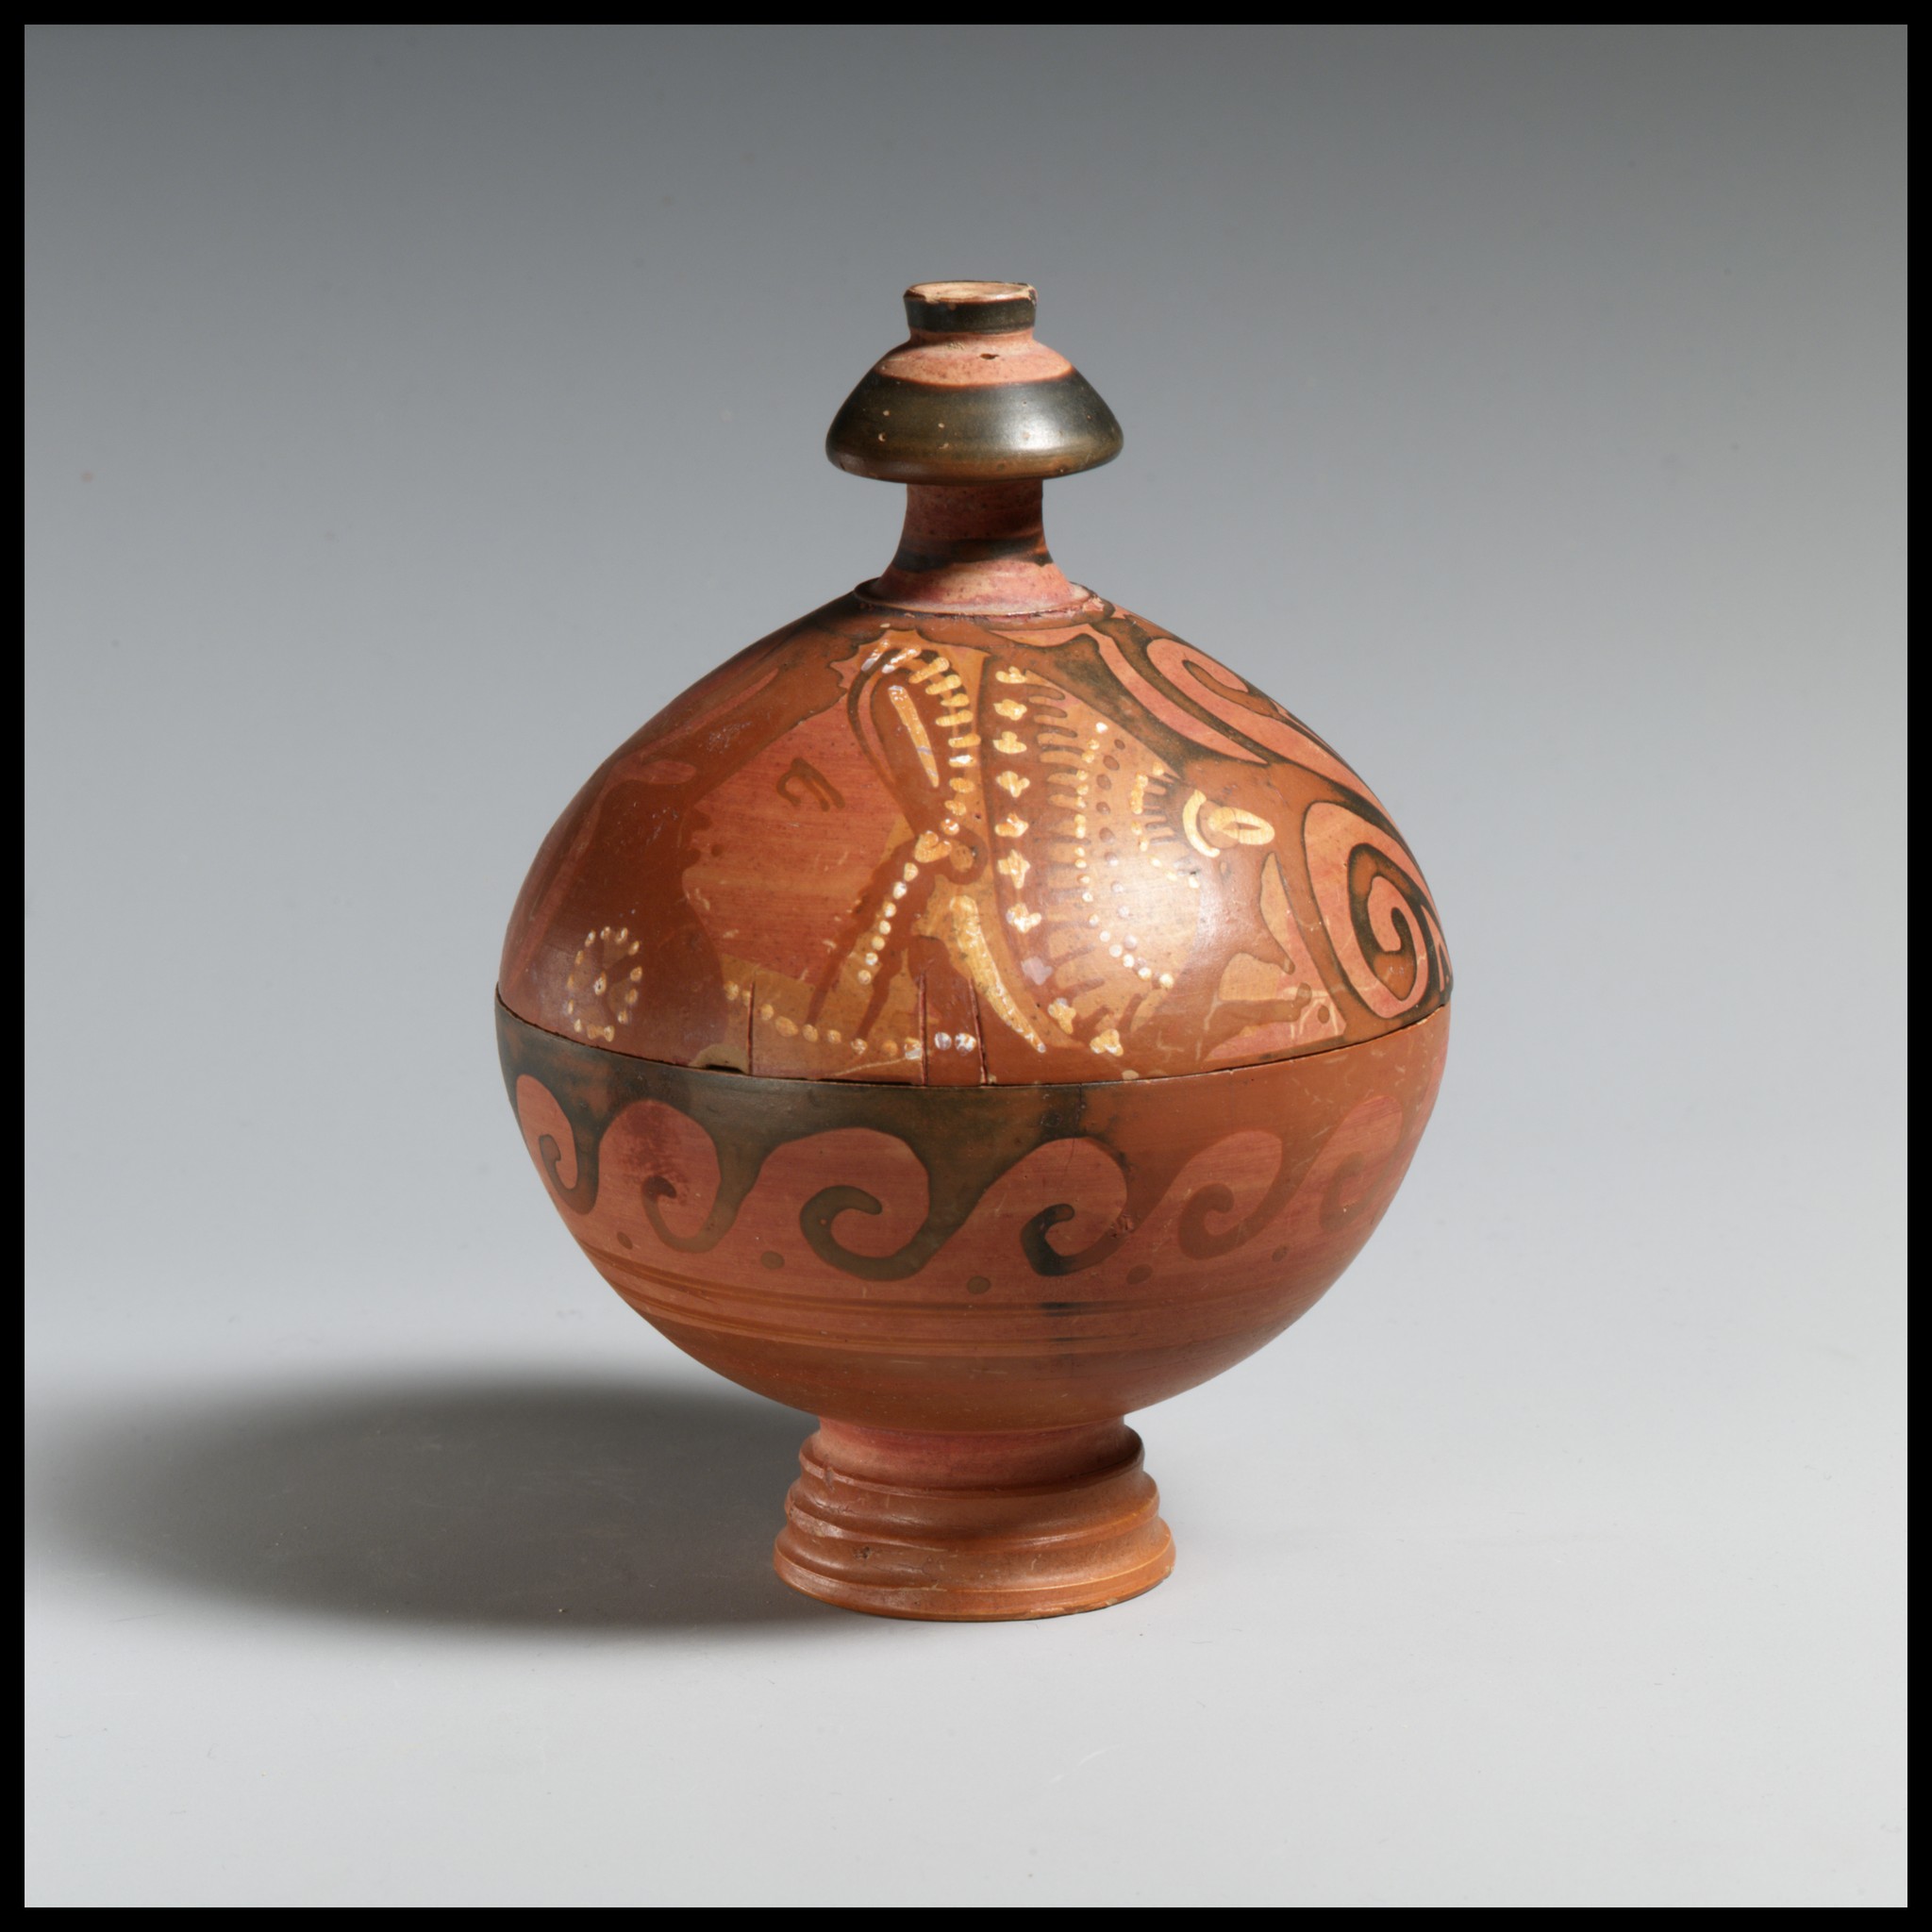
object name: pyxis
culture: greek, south italian, apulian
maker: kantharos group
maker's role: artist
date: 325-300 BCE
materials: terracotta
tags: heads,profiles,women